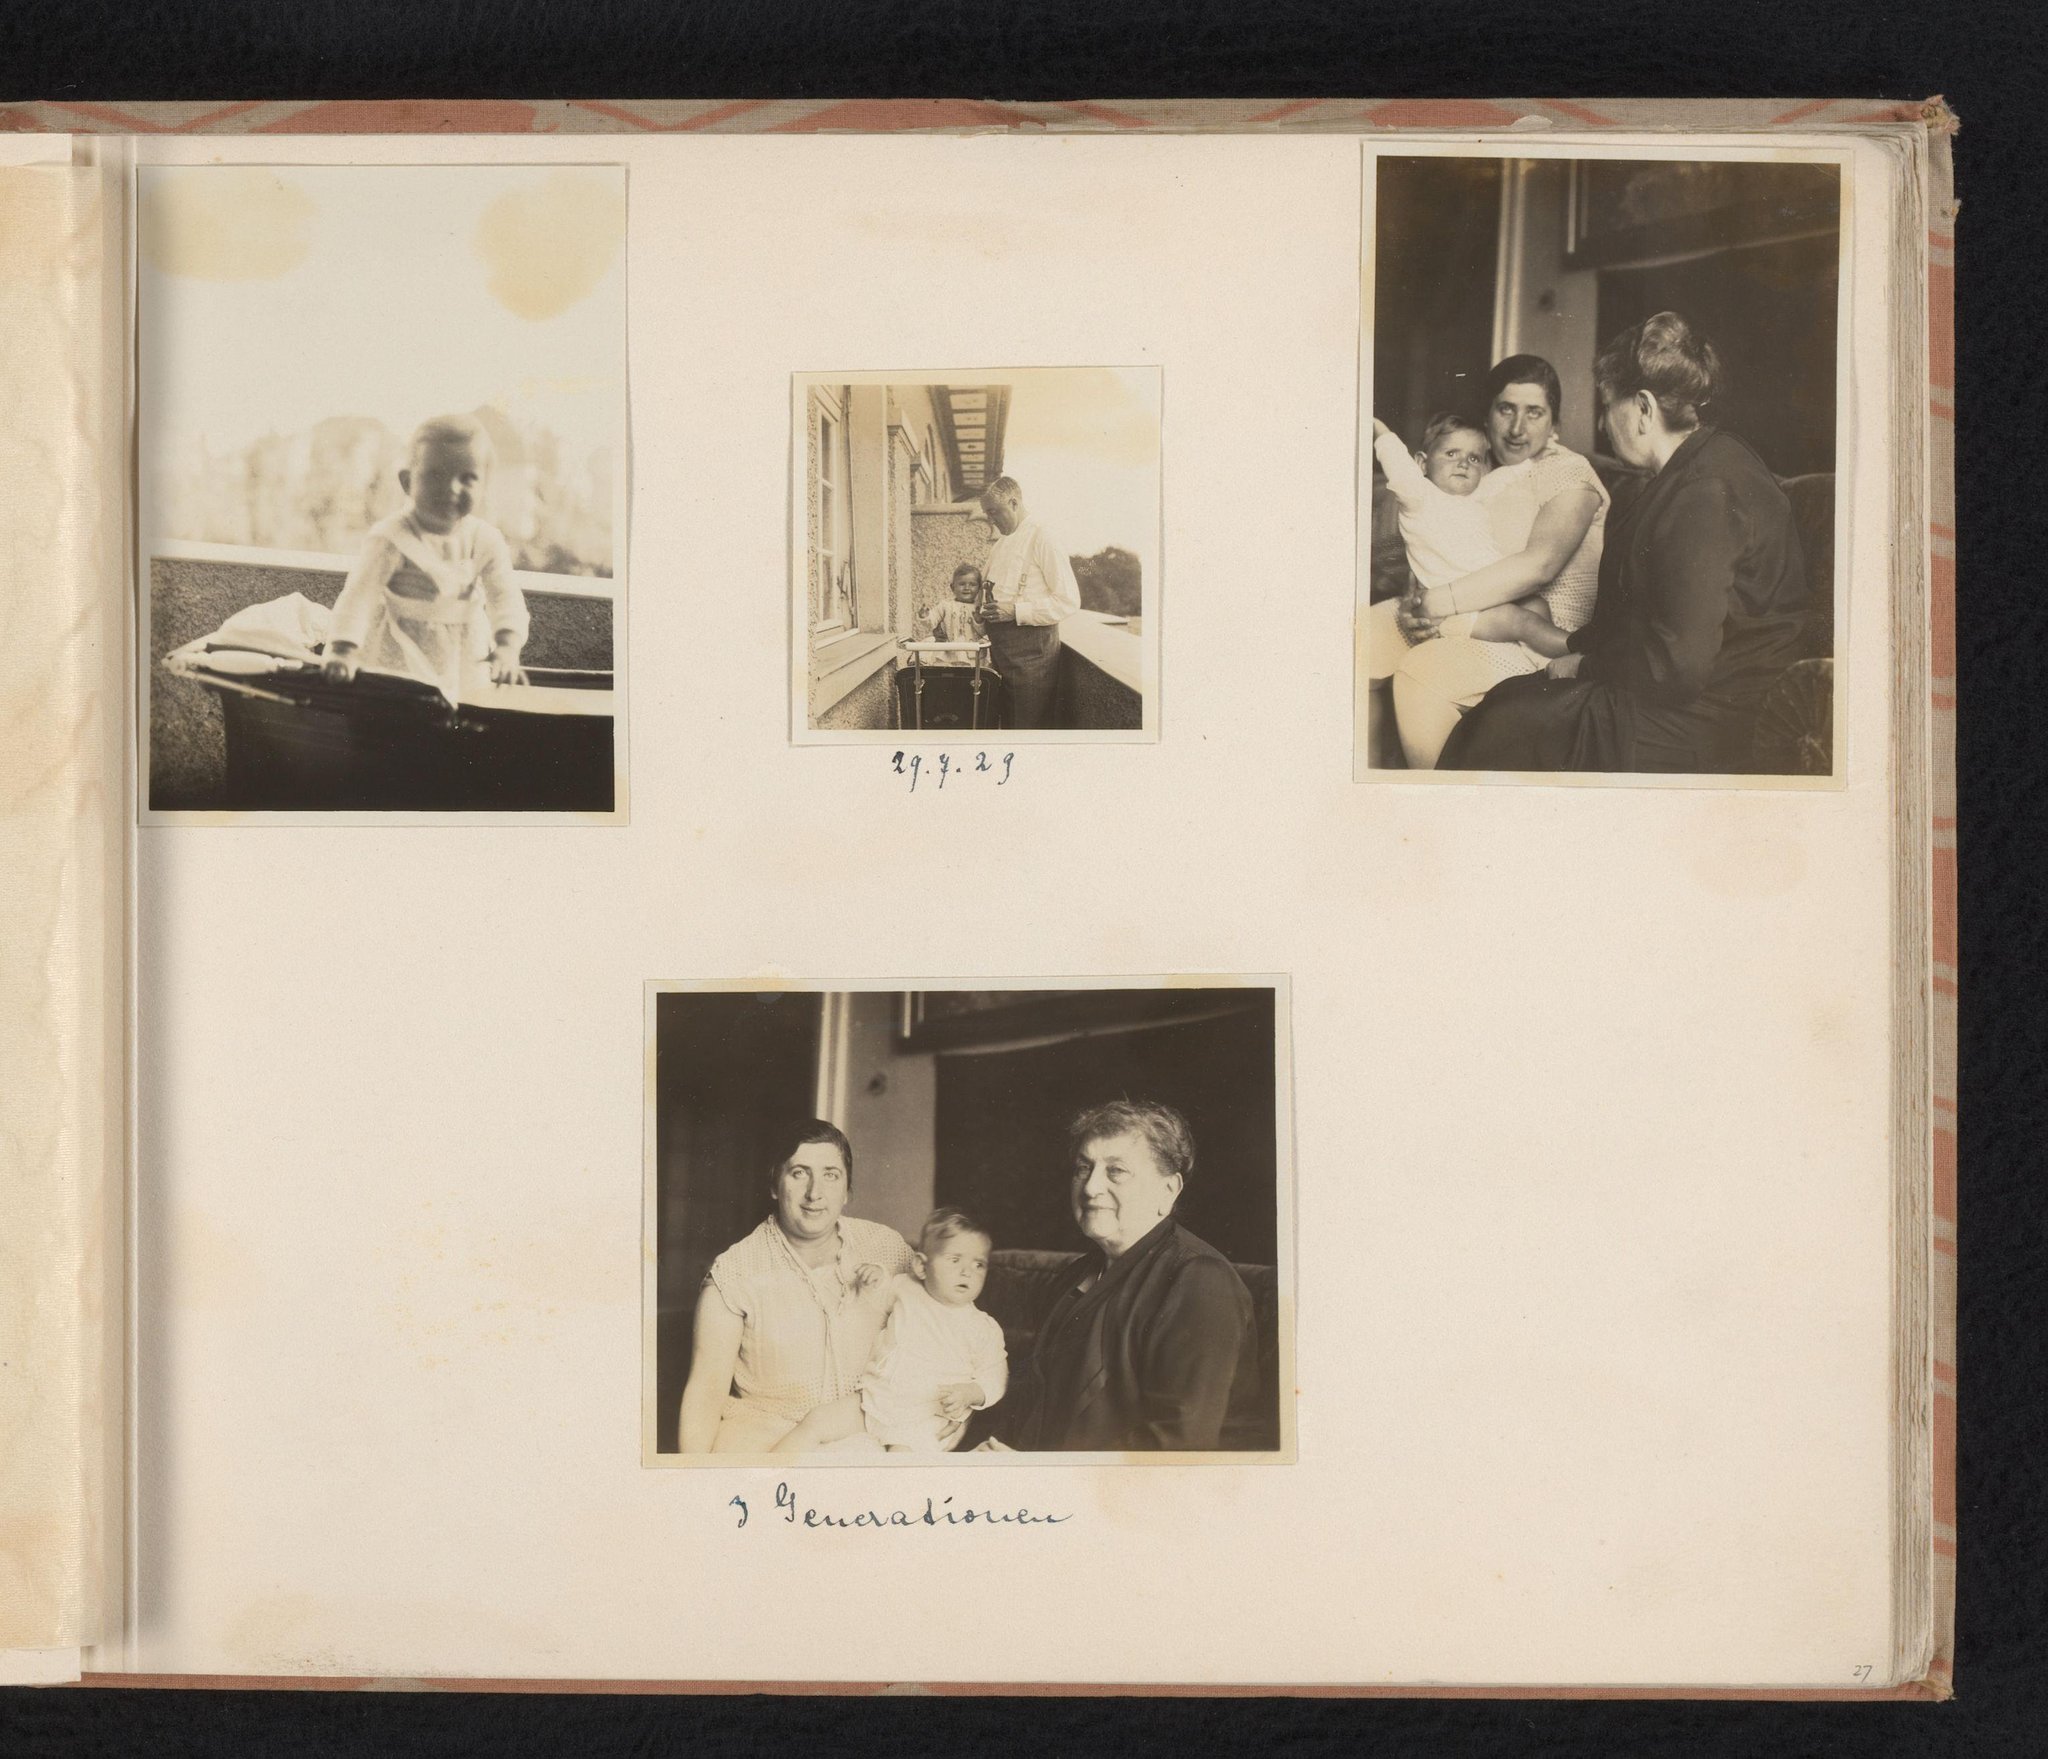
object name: photograph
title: Isabel Wachenheimer op het balkon met haar vader Eugen Wachenheimer en binnen met haar moeder Else Wachenheimer-Moos en grootmoeder Josefine Moos-Levi in de woning van de familie Wachenheimer (Herthastrasse 19), Neurenberg, 29 juli 1929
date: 1929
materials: paper, photographic support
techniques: gelatin silver print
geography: nuremberg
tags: eugen wachenheimer, else wachenheimer-moos, isabel wachenheimer-elon, josefine moos-levi, family life at home, mother and baby or young child, infant, baby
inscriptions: inscription: ‘29.7.29//3 Generationen’